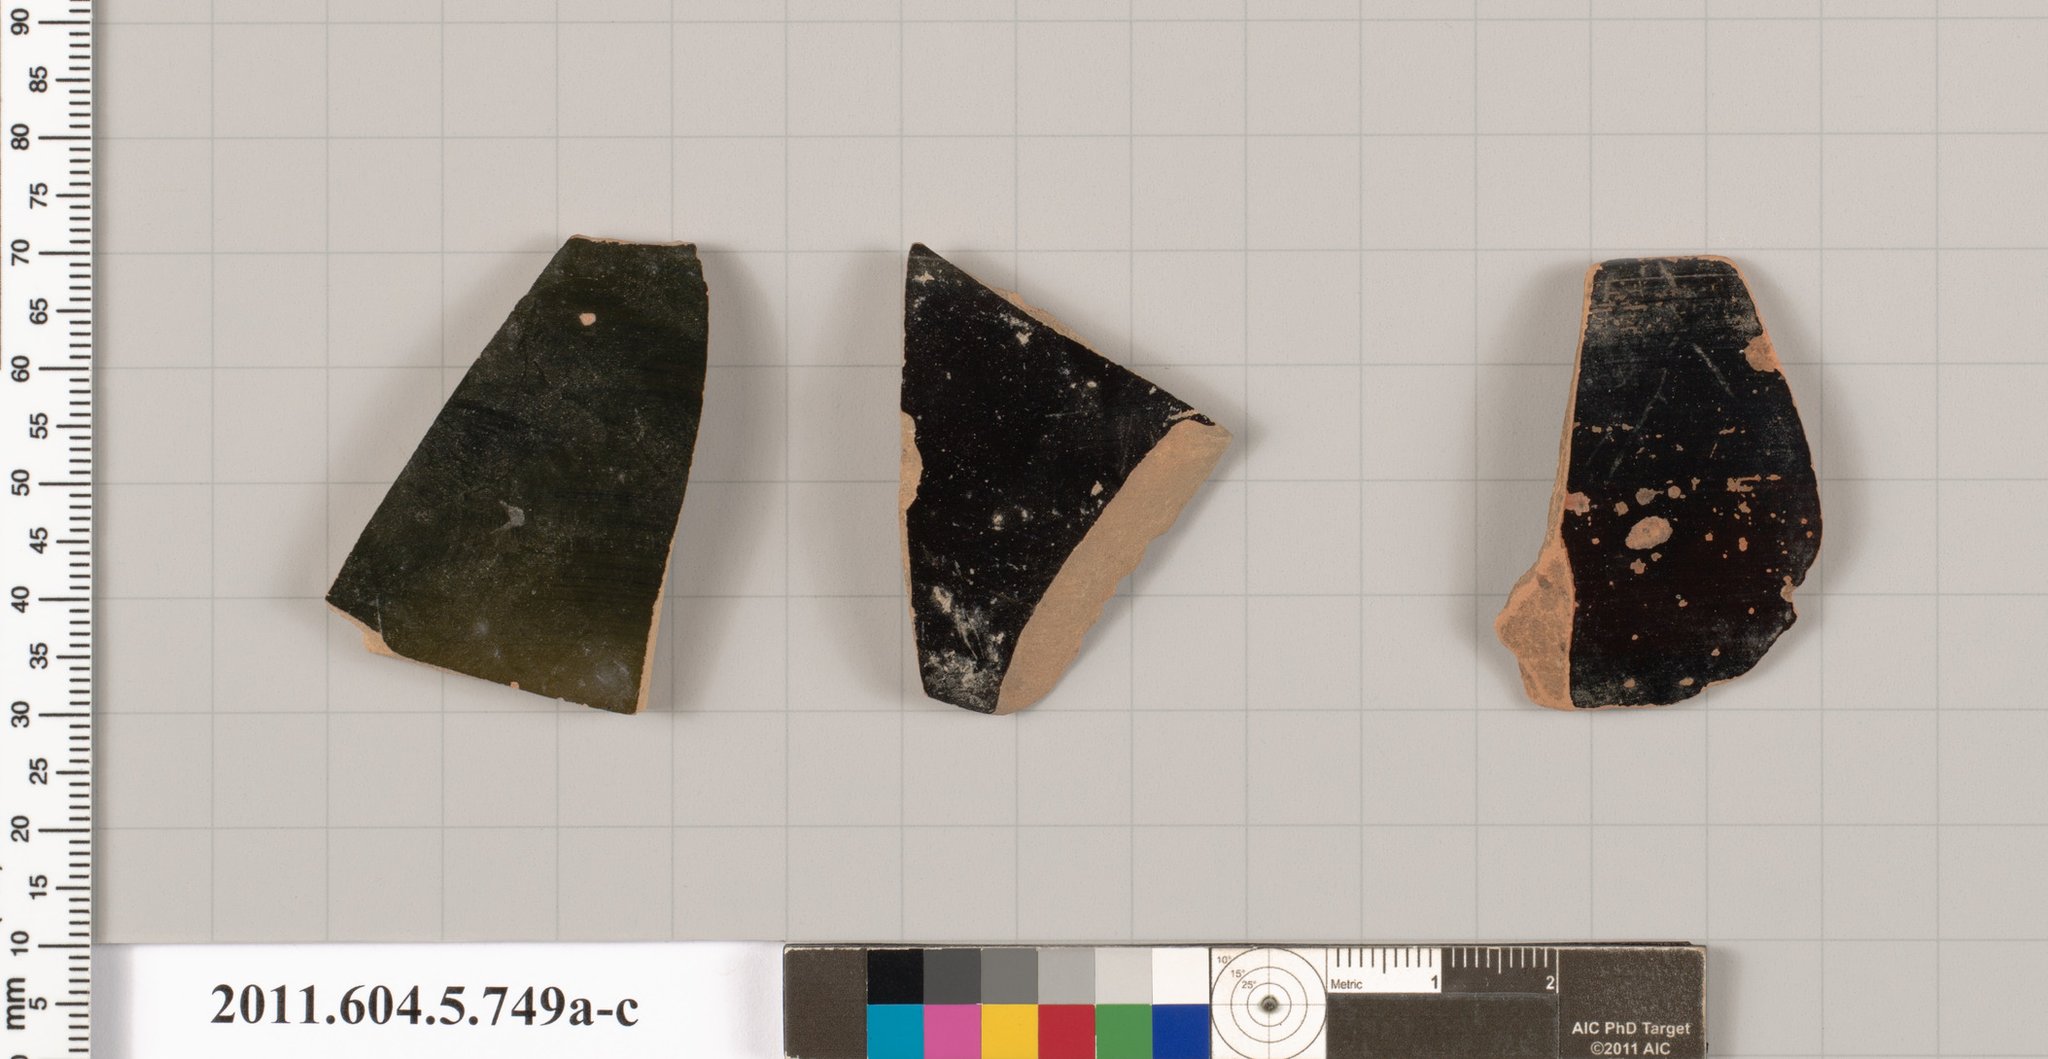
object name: kylix fragment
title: Terracotta fragments of kylikes (drinking cups)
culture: greek, attic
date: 600-401 BCE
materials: terracotta